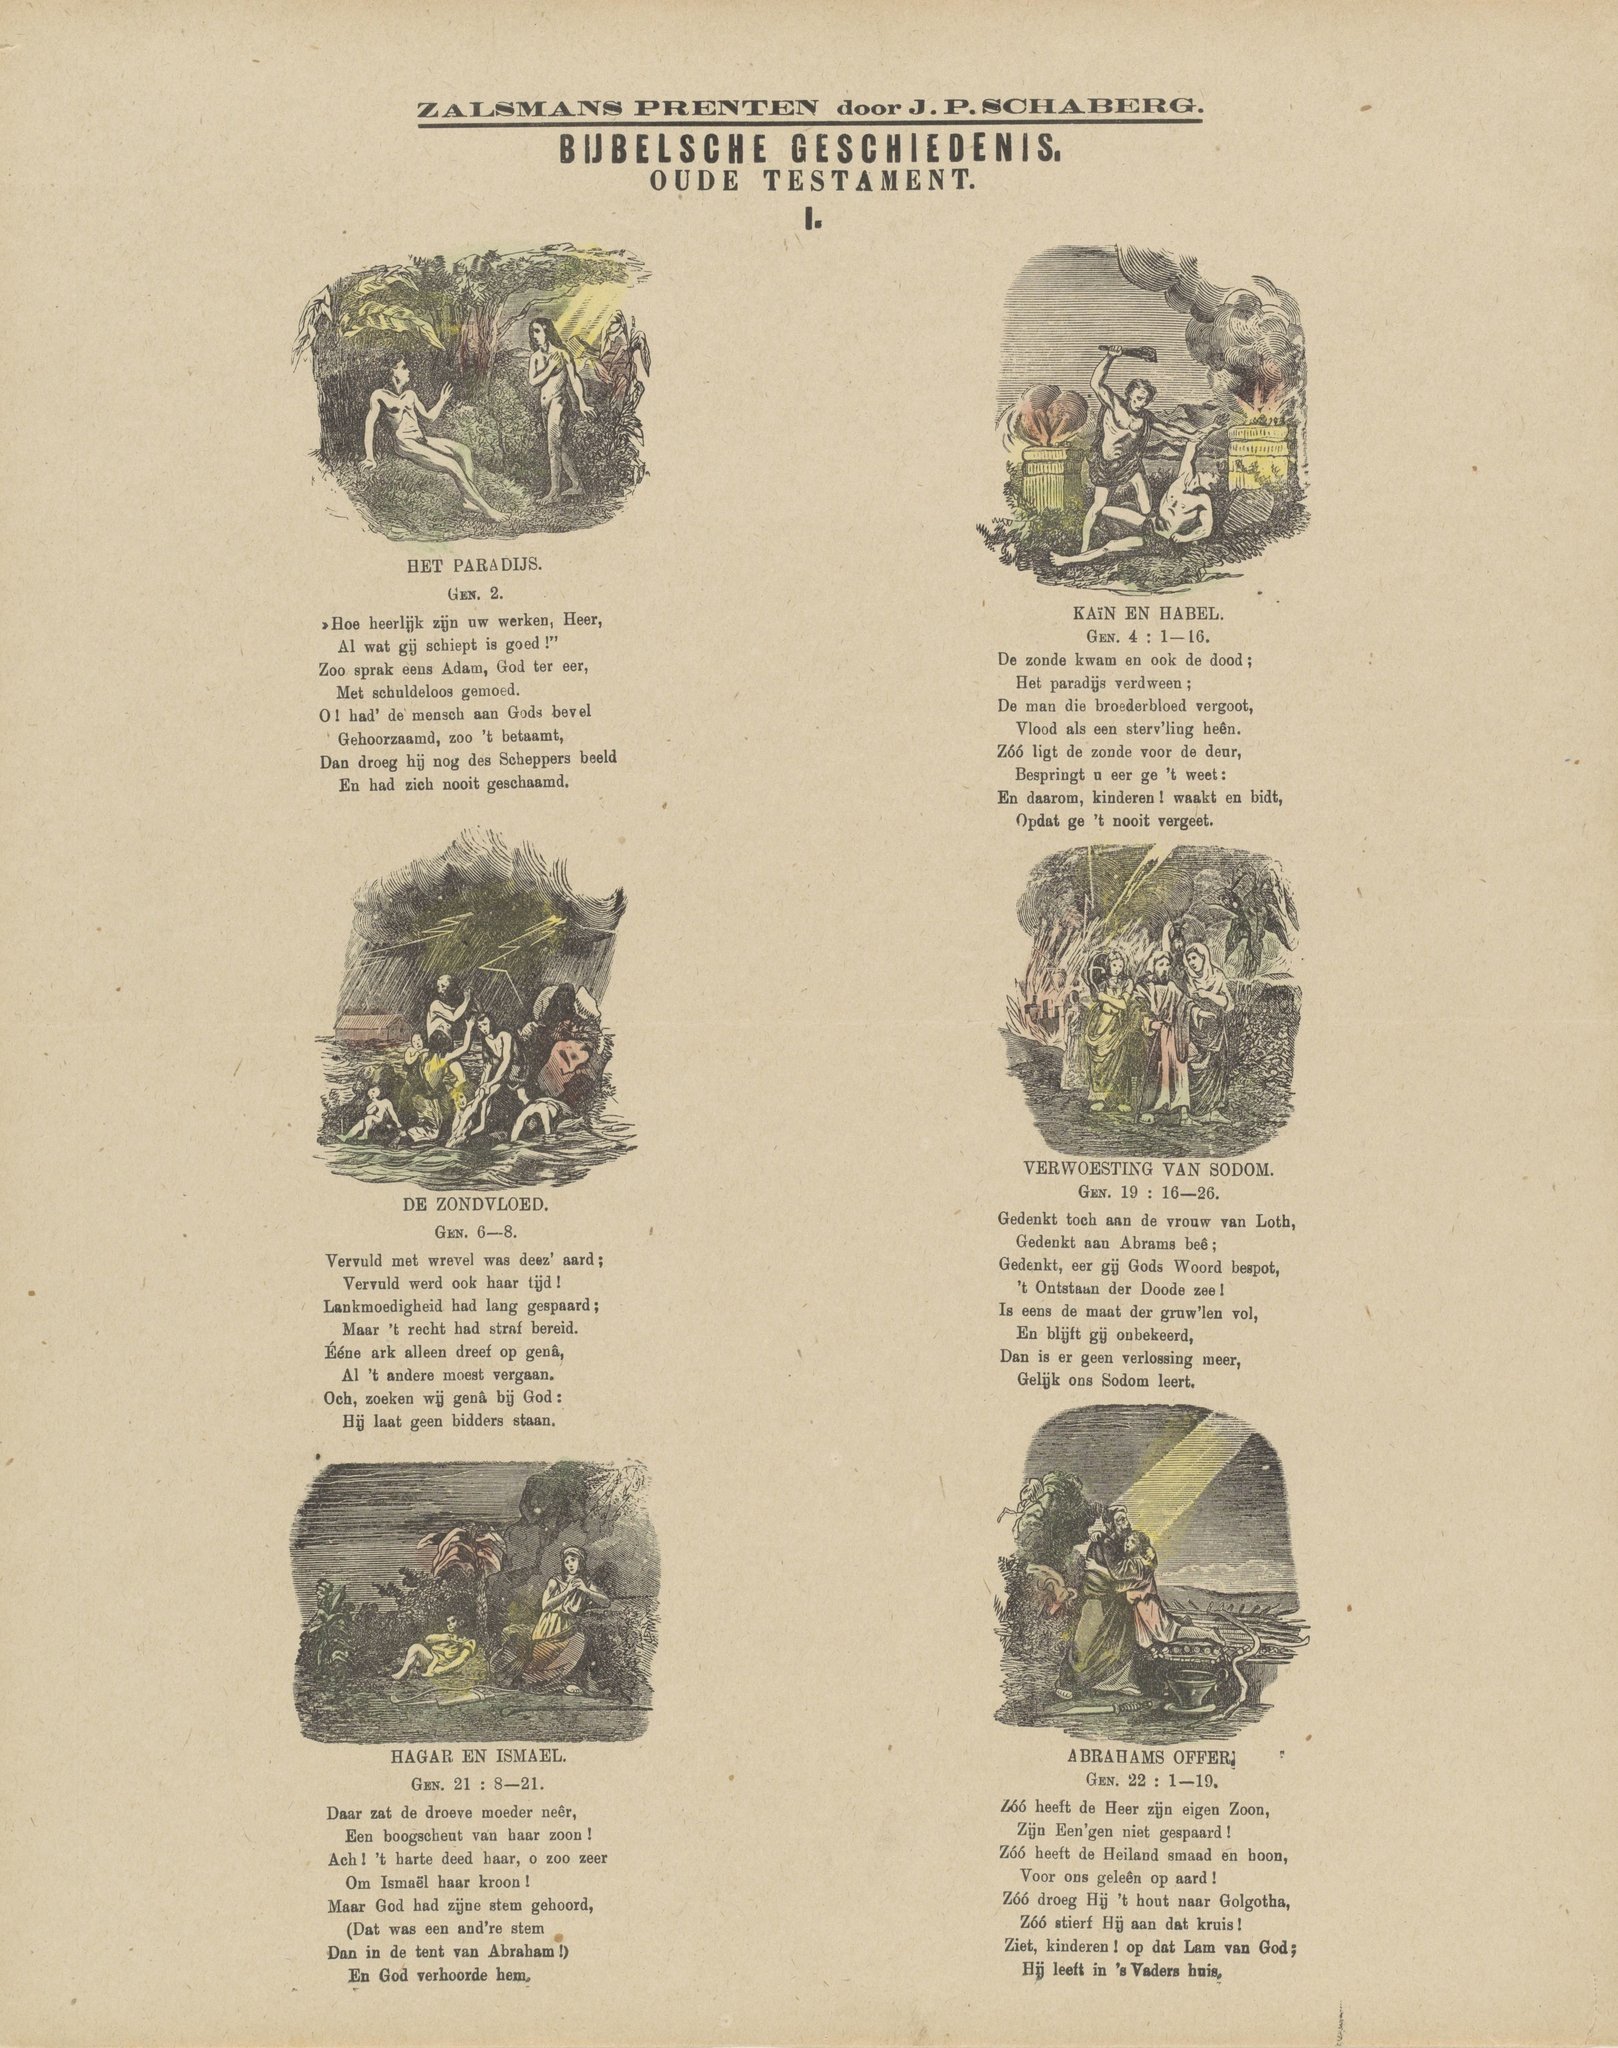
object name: print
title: Zalmans prenten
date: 1869-1882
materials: paper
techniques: colour, letterpress printing, engraving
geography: europe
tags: old testament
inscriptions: collector's mark: Lugt 2760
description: Blad met 6 voorstellingen van verhalen uit het Oude Testament. Onder elke voorstelling een achtregelig vers en een verwijzing naar de bijbehorende Bijbeltekst. Genummerd midden boven: I.